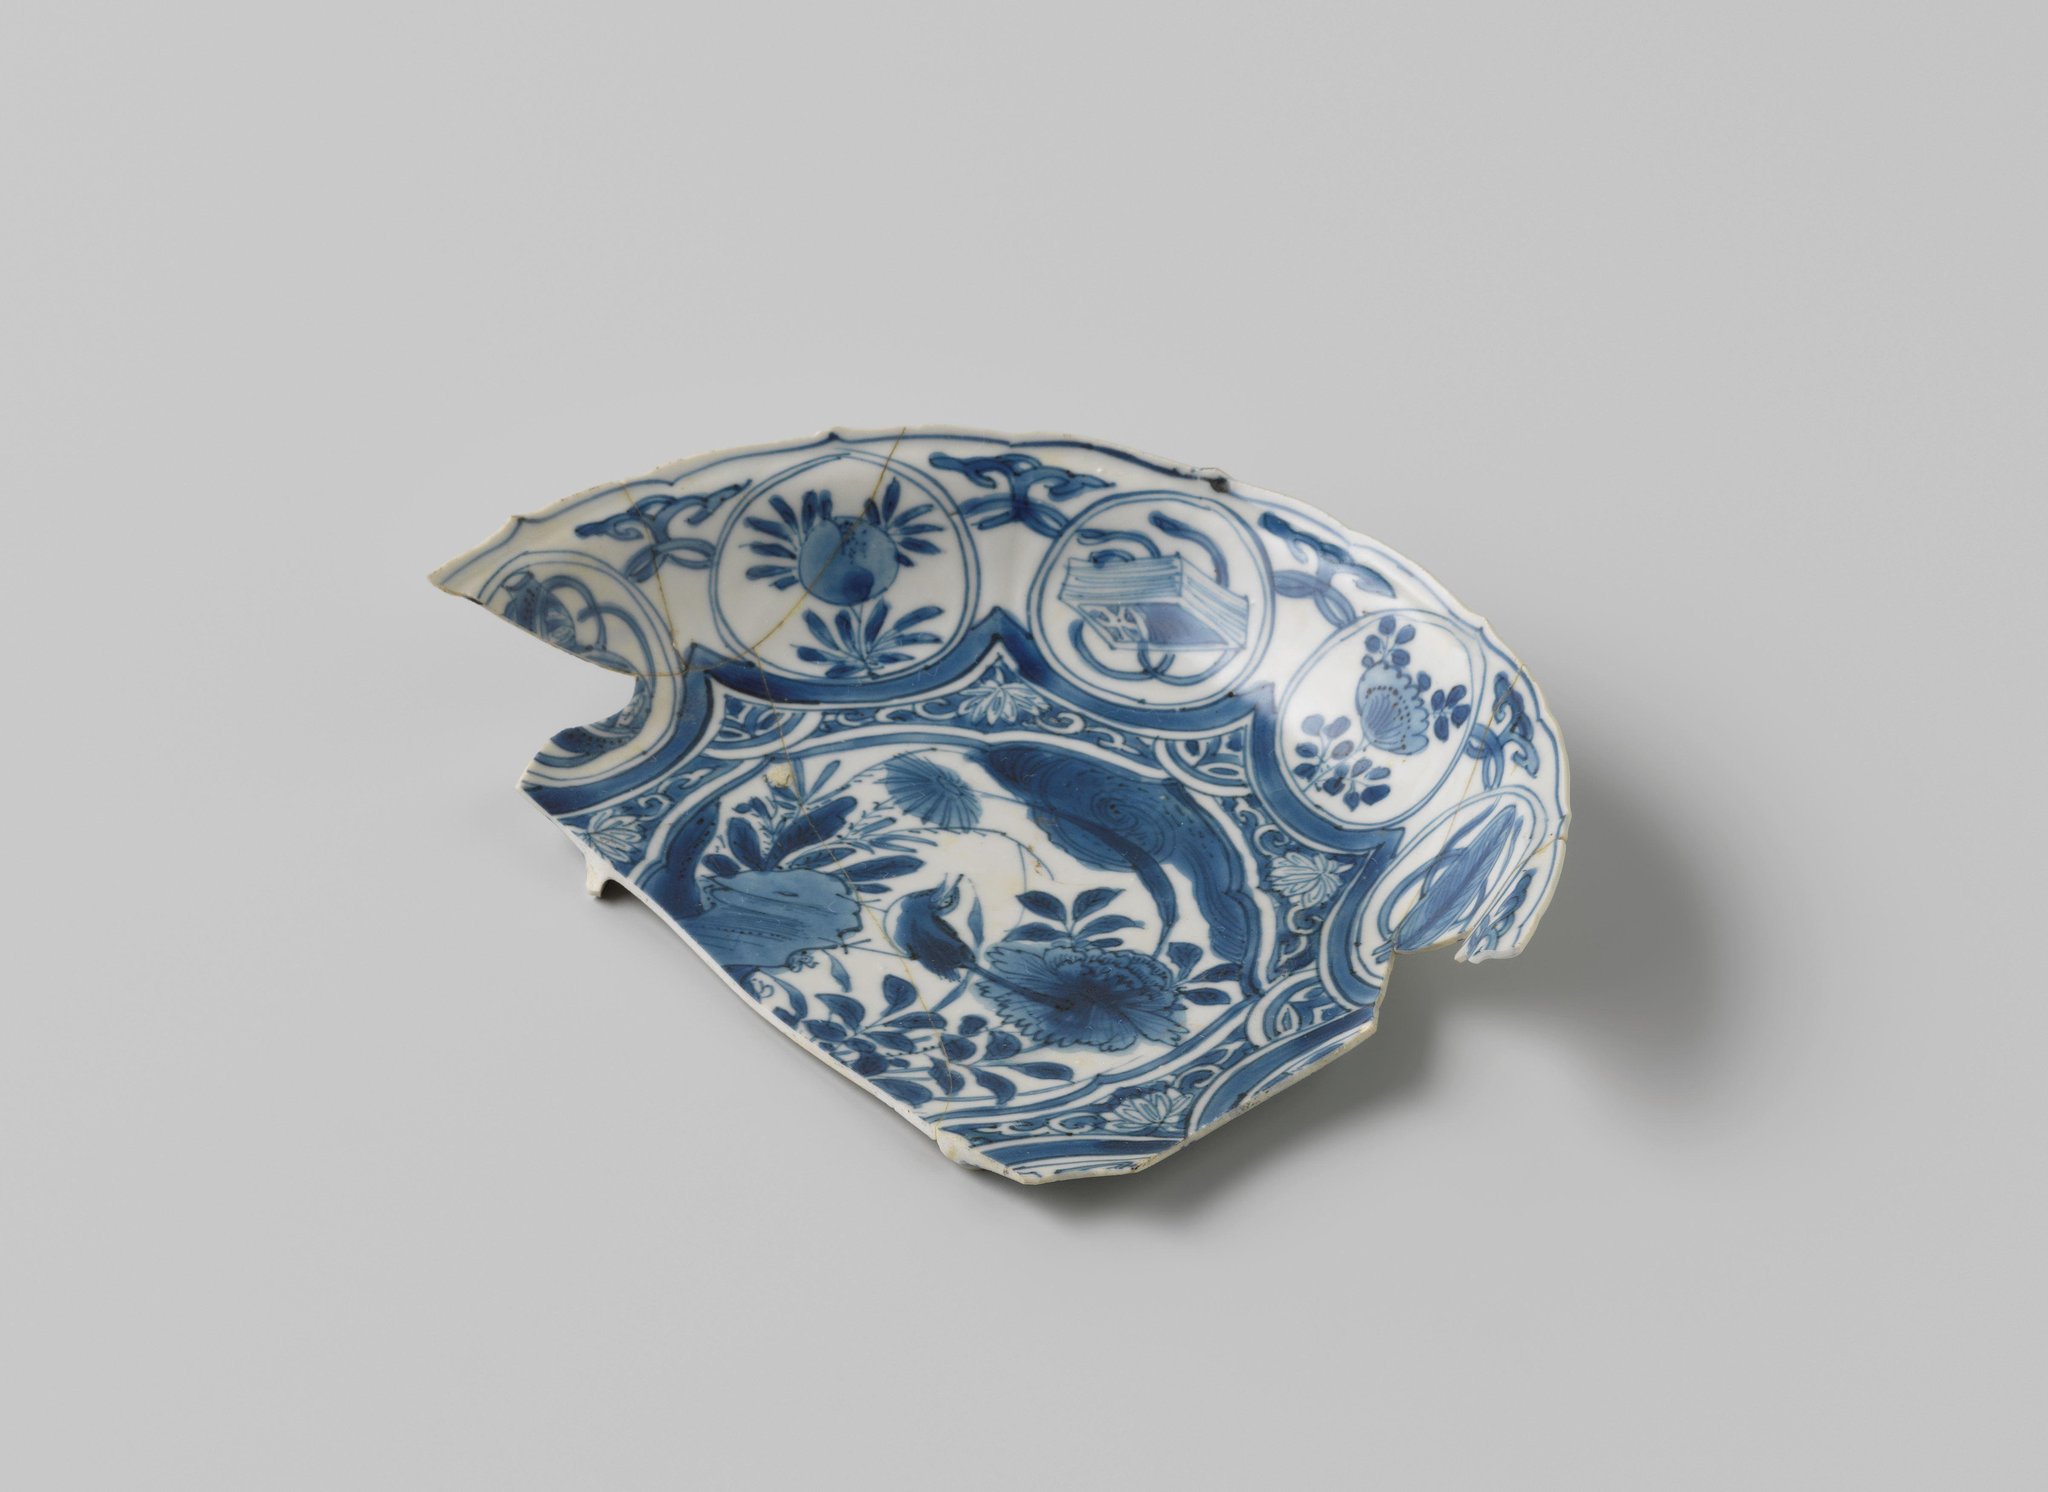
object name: sherd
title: Fragment bord uit V.O.C.-schip de 'Witte leeuw'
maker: Anonymous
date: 1613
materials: bone china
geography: jingdezhen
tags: verenigde oostindische compagnie, sint-helena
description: A dish without a flattened rim. A scalloped medallion with 5 rui heads within a star-shaped medallion filled with various diaper patterns. A central decoration of a bird under a peony. The encircling medallion has a diaper pattern of lotusflowers on a blue background. The medallions decorated with a flower or peach and a symbol.